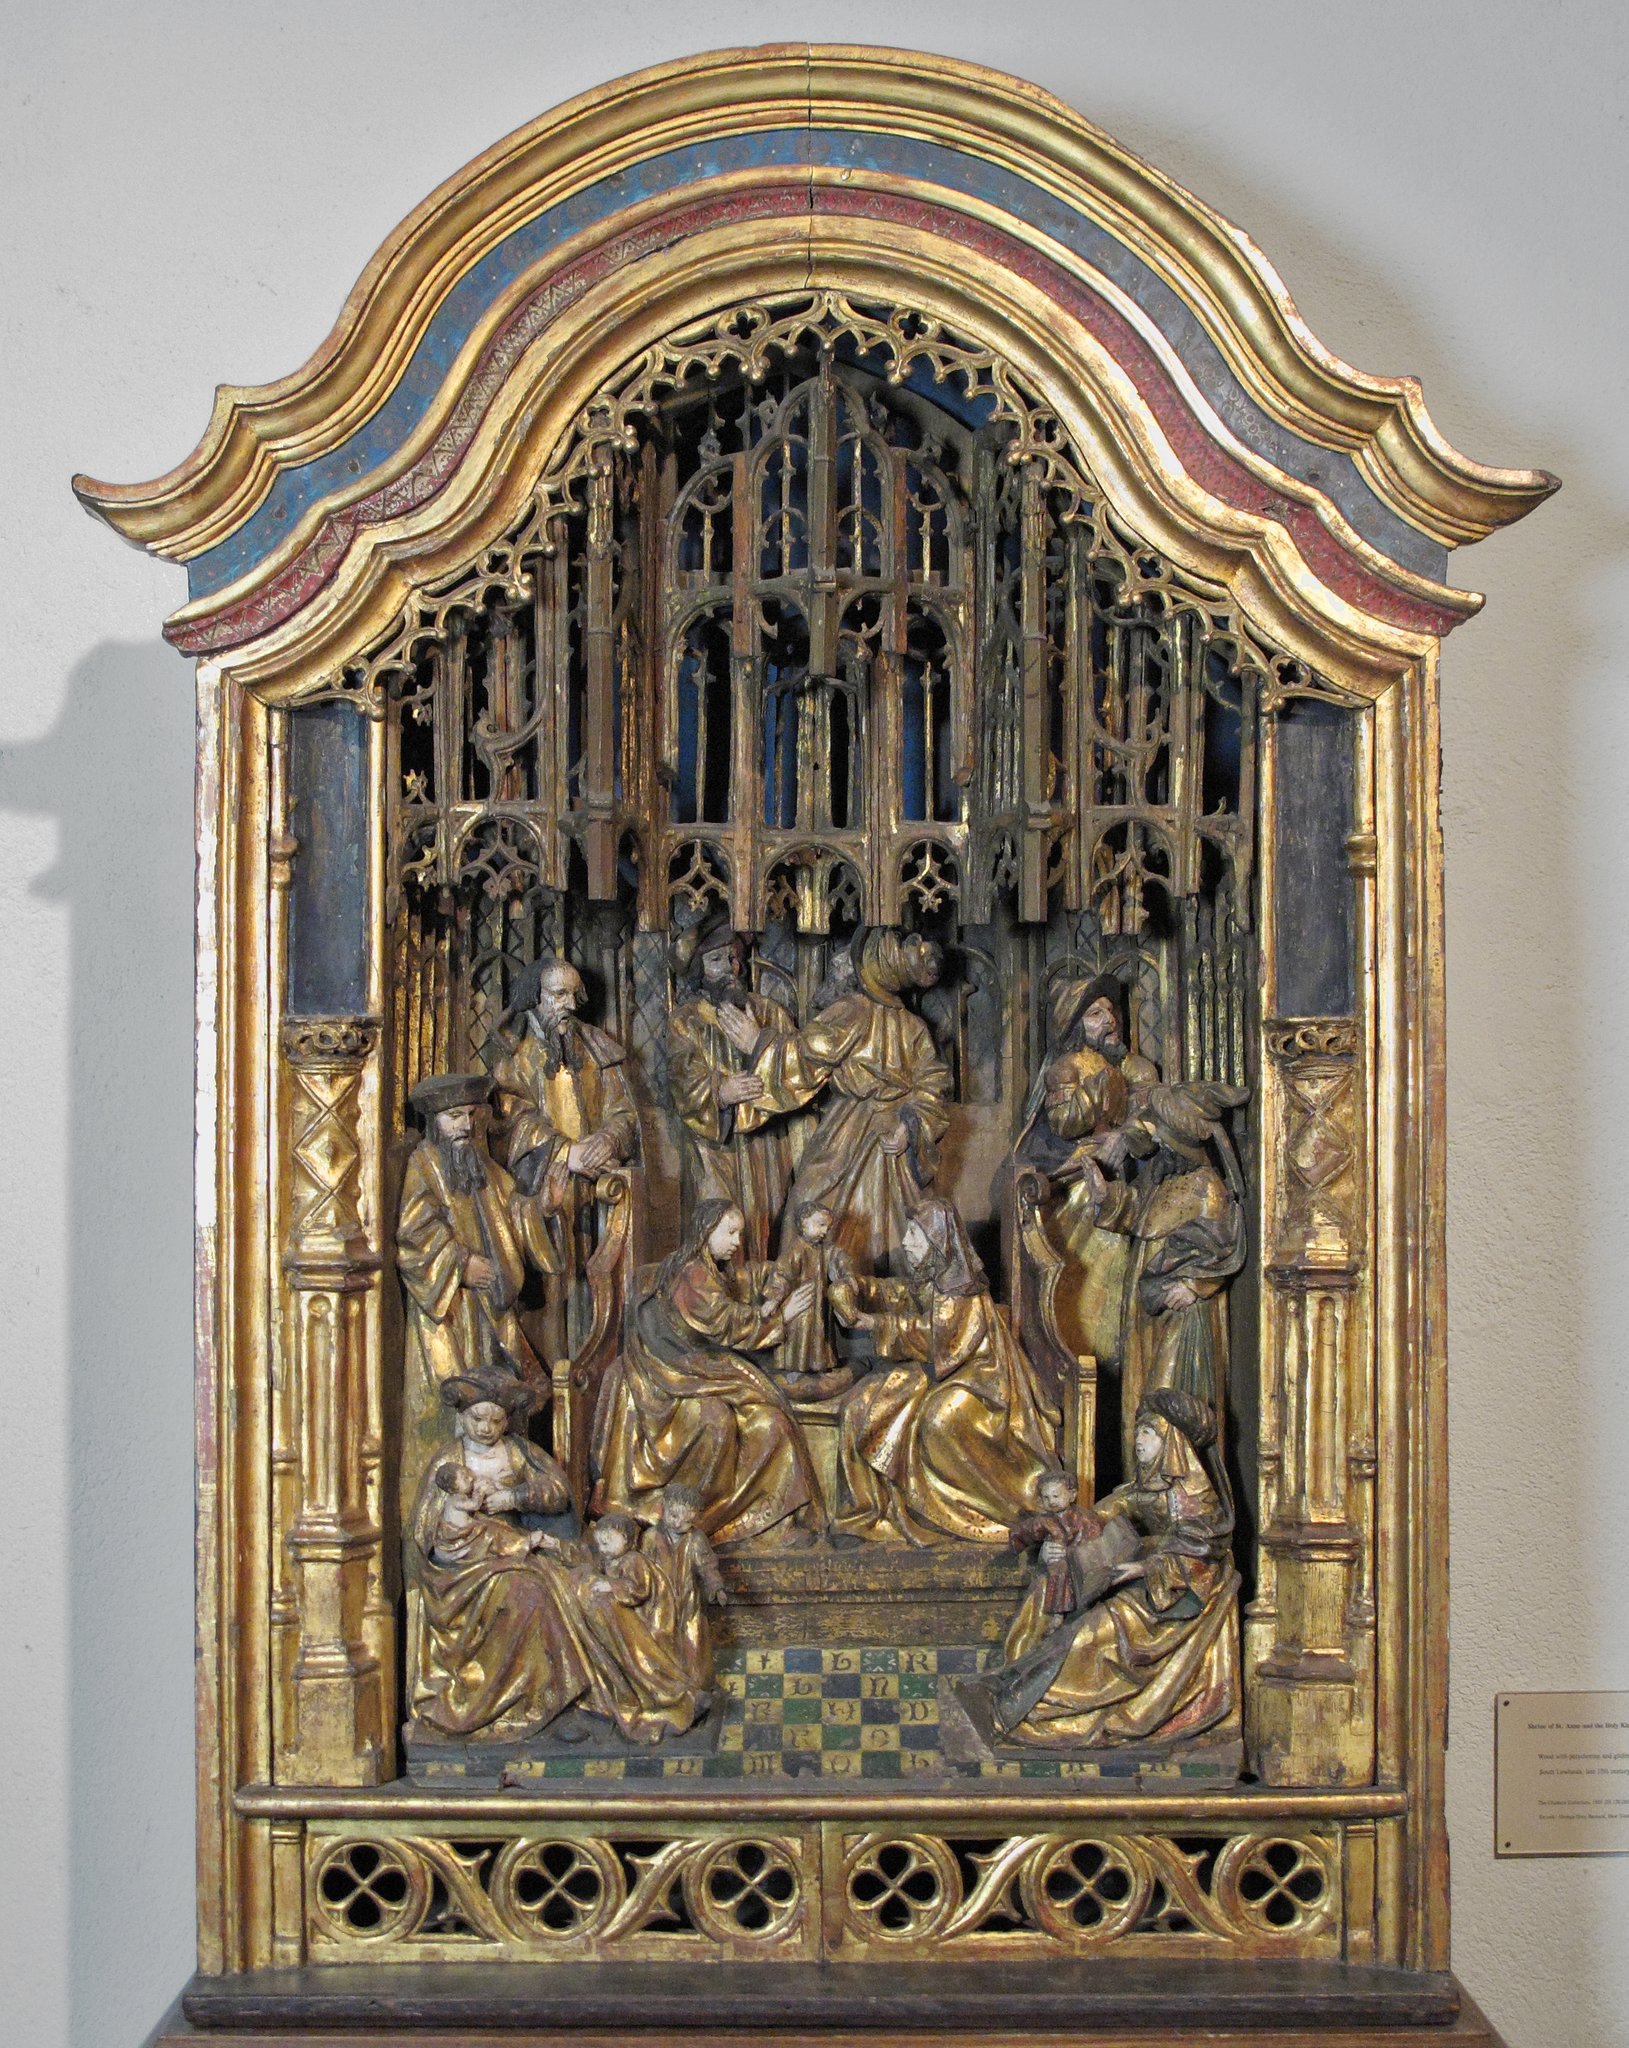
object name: shrine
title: Shrine of Saint Anne and the Holy Kinship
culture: south netherlandish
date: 1467-1500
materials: gilt, paint, wood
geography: antwerp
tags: apostles,saint anne,virgin mary,jesus